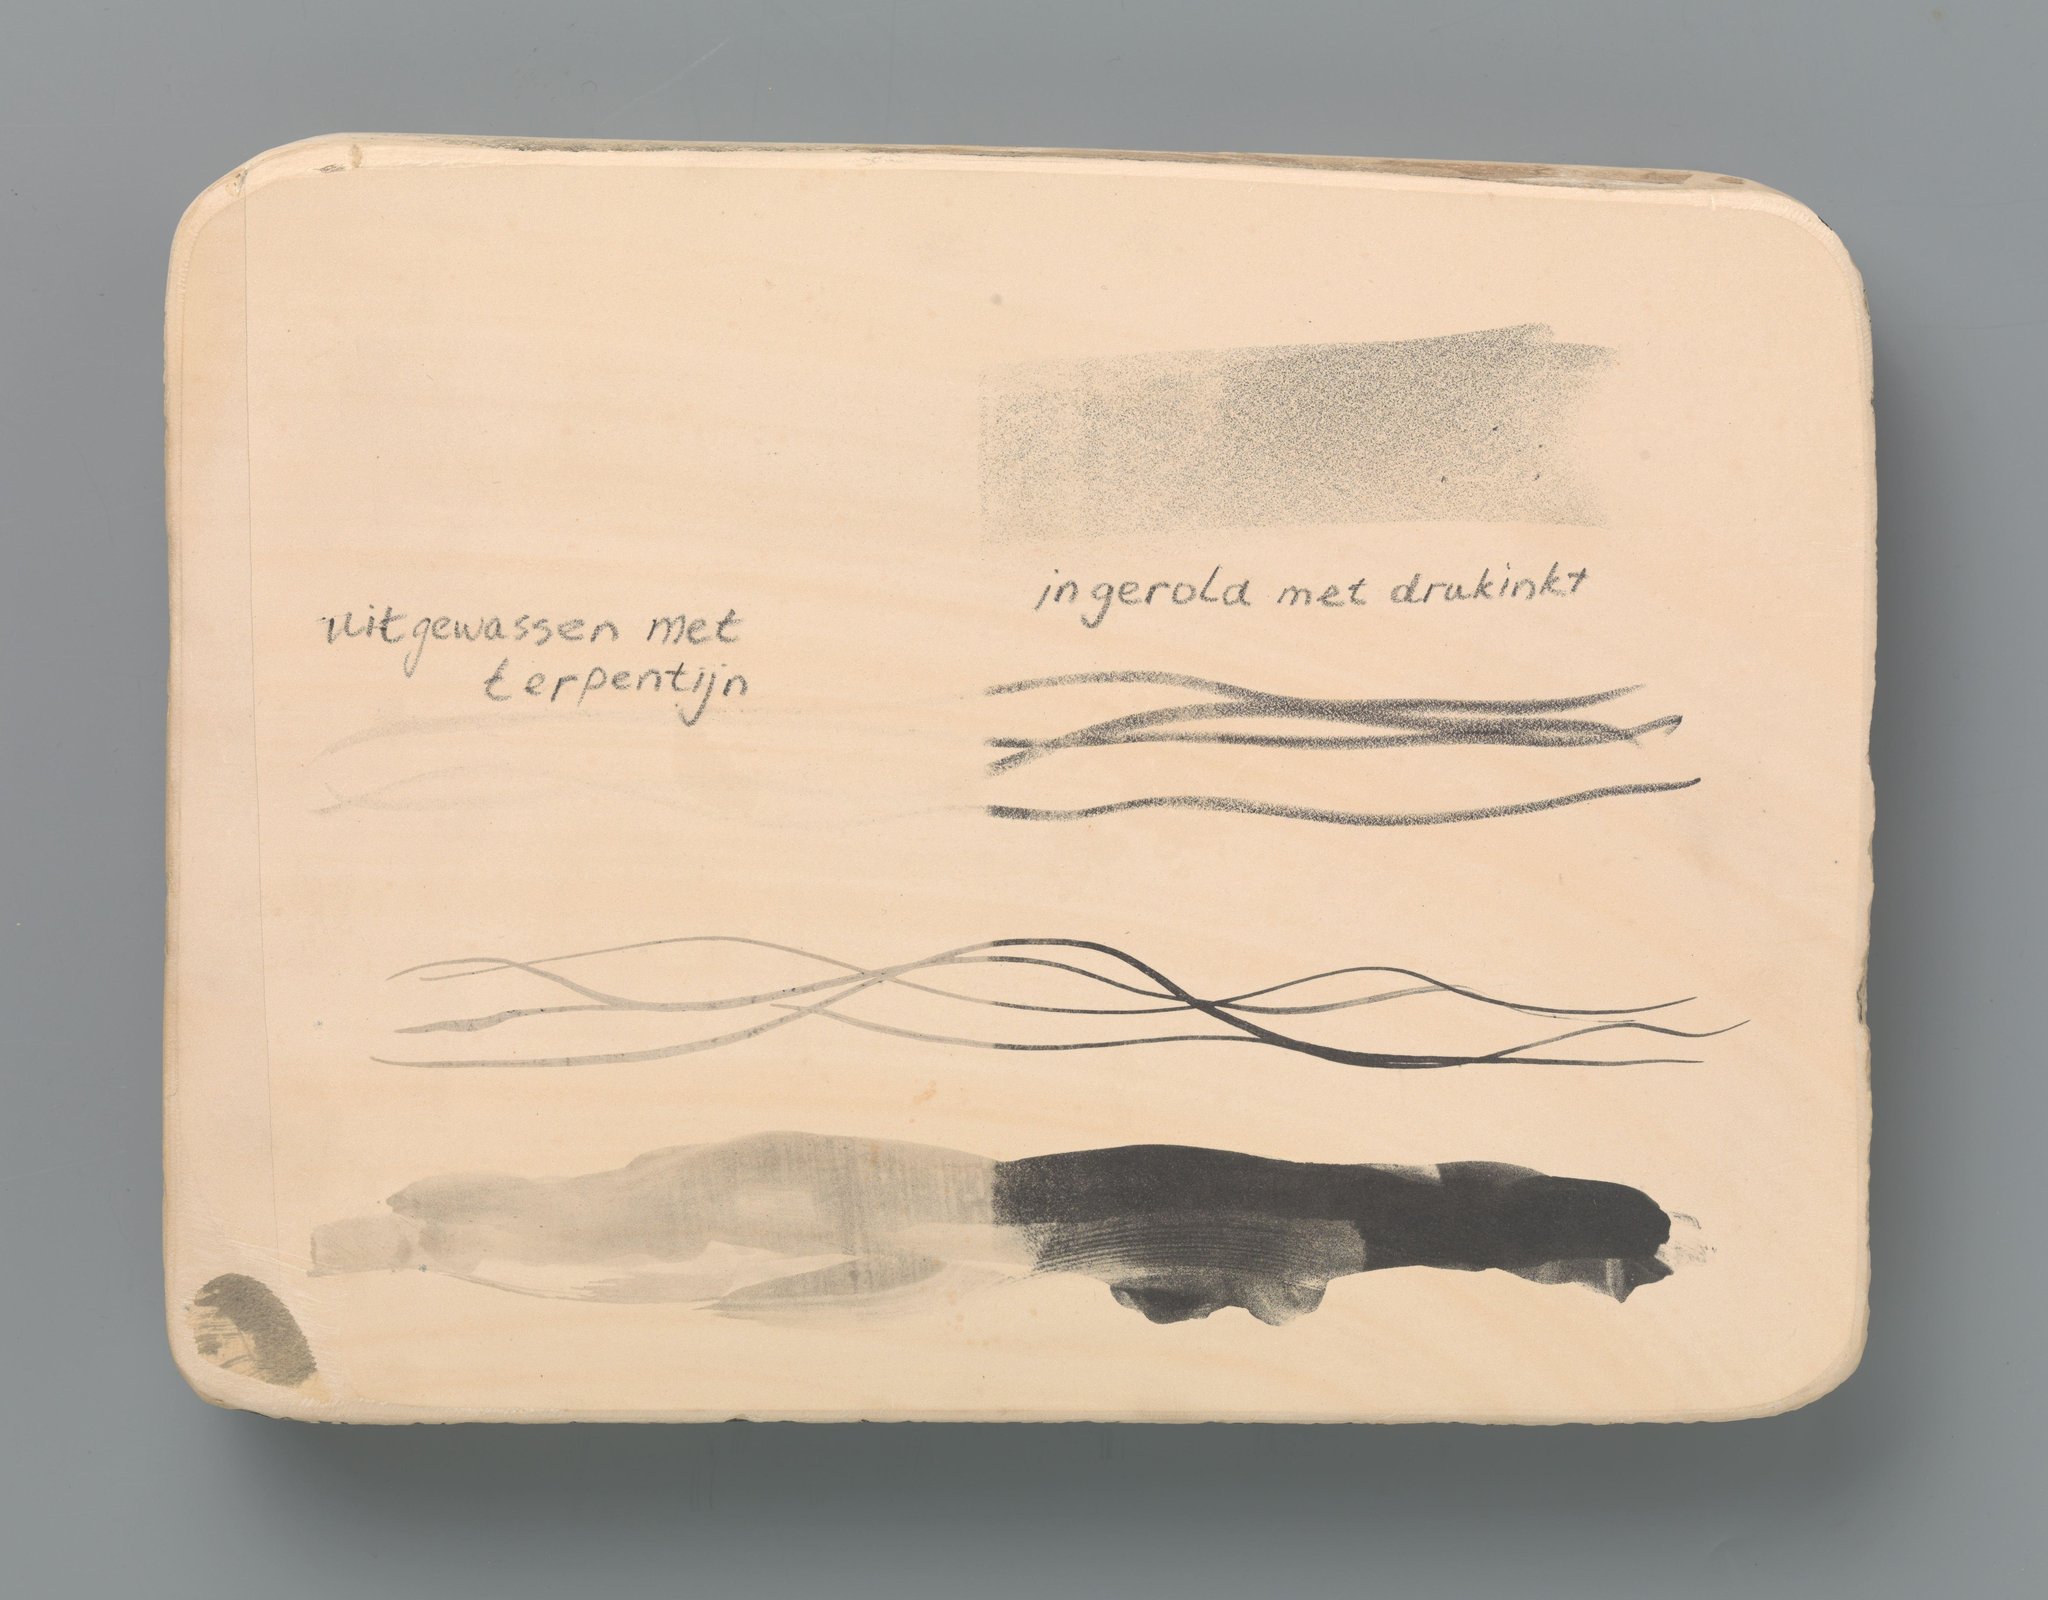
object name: lithographic stone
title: Lithosteen, betekend met verschillende materialen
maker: Anonymous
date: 1970-1990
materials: stone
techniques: lithograph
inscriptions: annotation: ‘uitgewassen met terpentijn / ingerold met drukinkt’